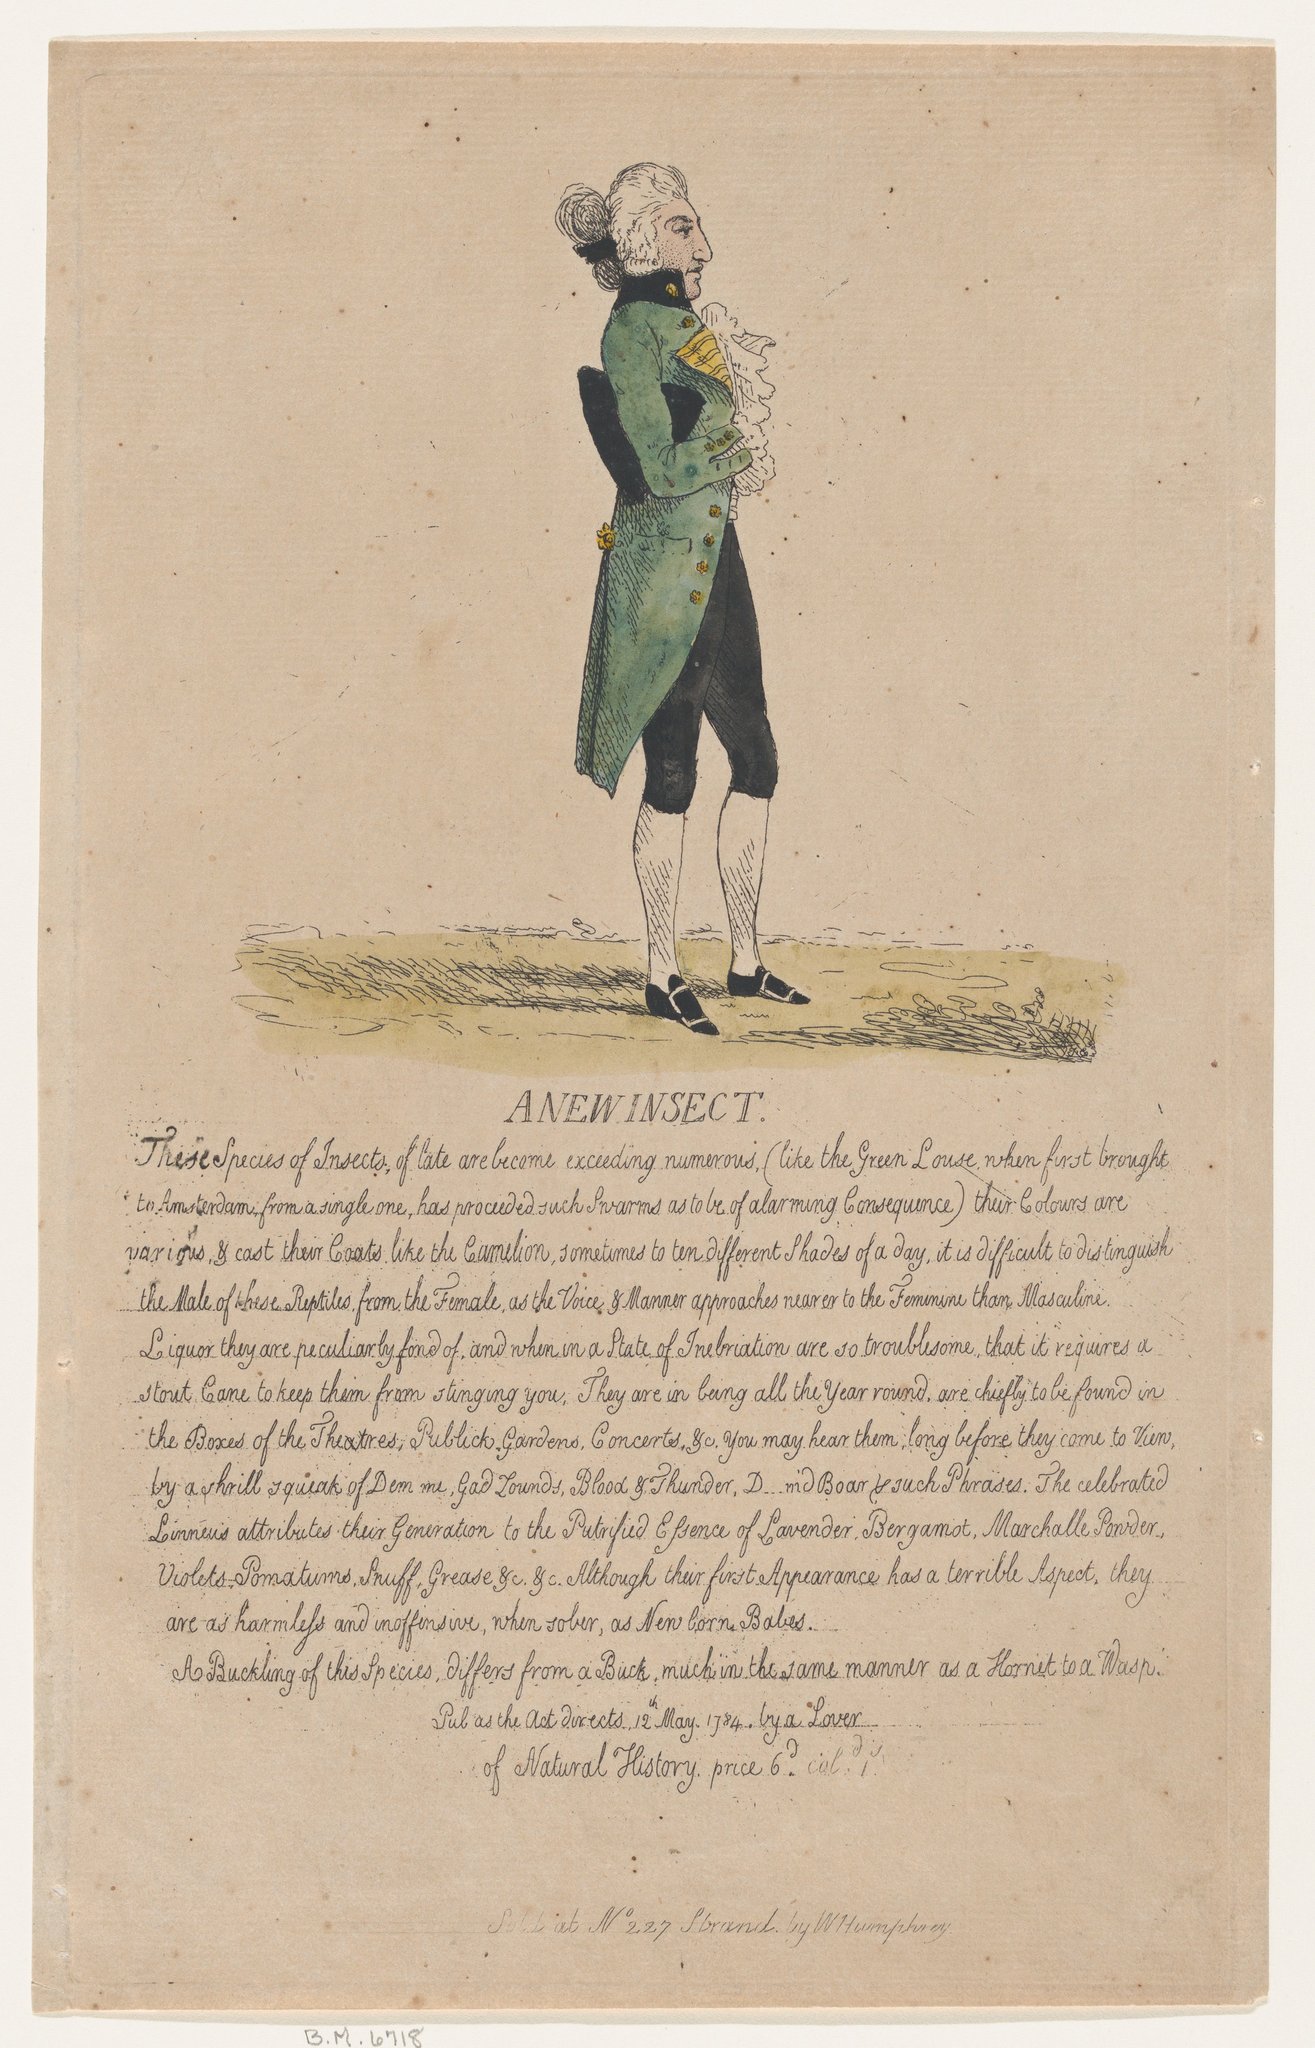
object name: print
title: A New Insect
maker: thomas rowlandson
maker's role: artist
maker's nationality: british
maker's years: 1757-1827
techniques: etching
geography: london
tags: men